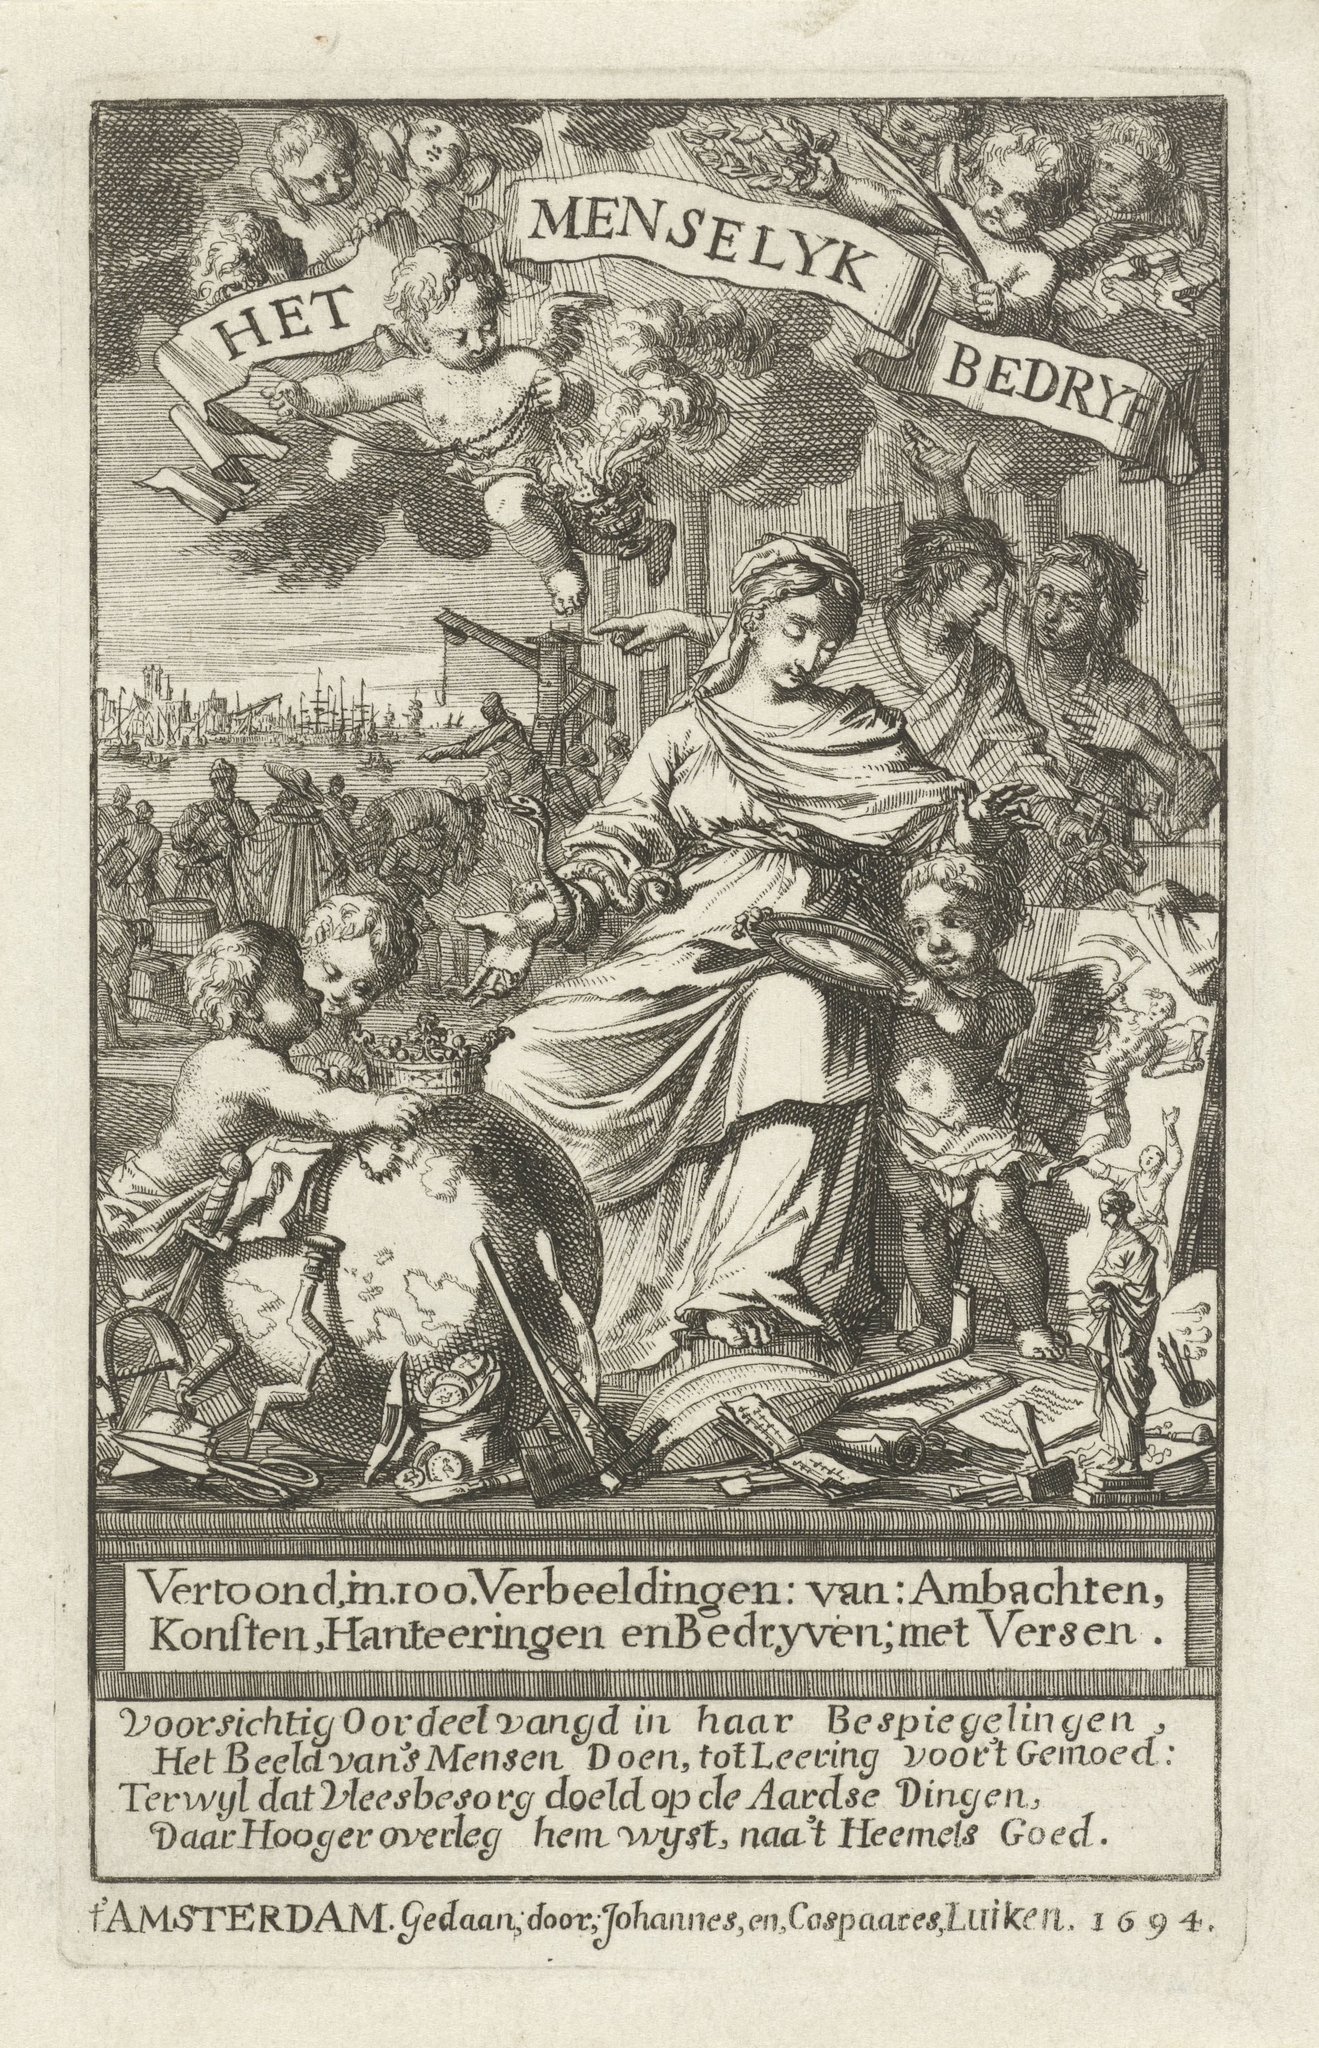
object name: titelprent, frontispice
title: Vrouw onderwijst drie kinderen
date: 1694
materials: paper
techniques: etching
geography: amsterdam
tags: teacher and pupil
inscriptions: collector's mark: Lugt 2760, collector's mark: Lugt 2228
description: Zittende vrouw onderwijst drie kinderen die om haar heen staan. Op de voorgrond liggen allerlei voorwerpen die bij verschillende arbeid gebruikt worden. In de marge een vers.